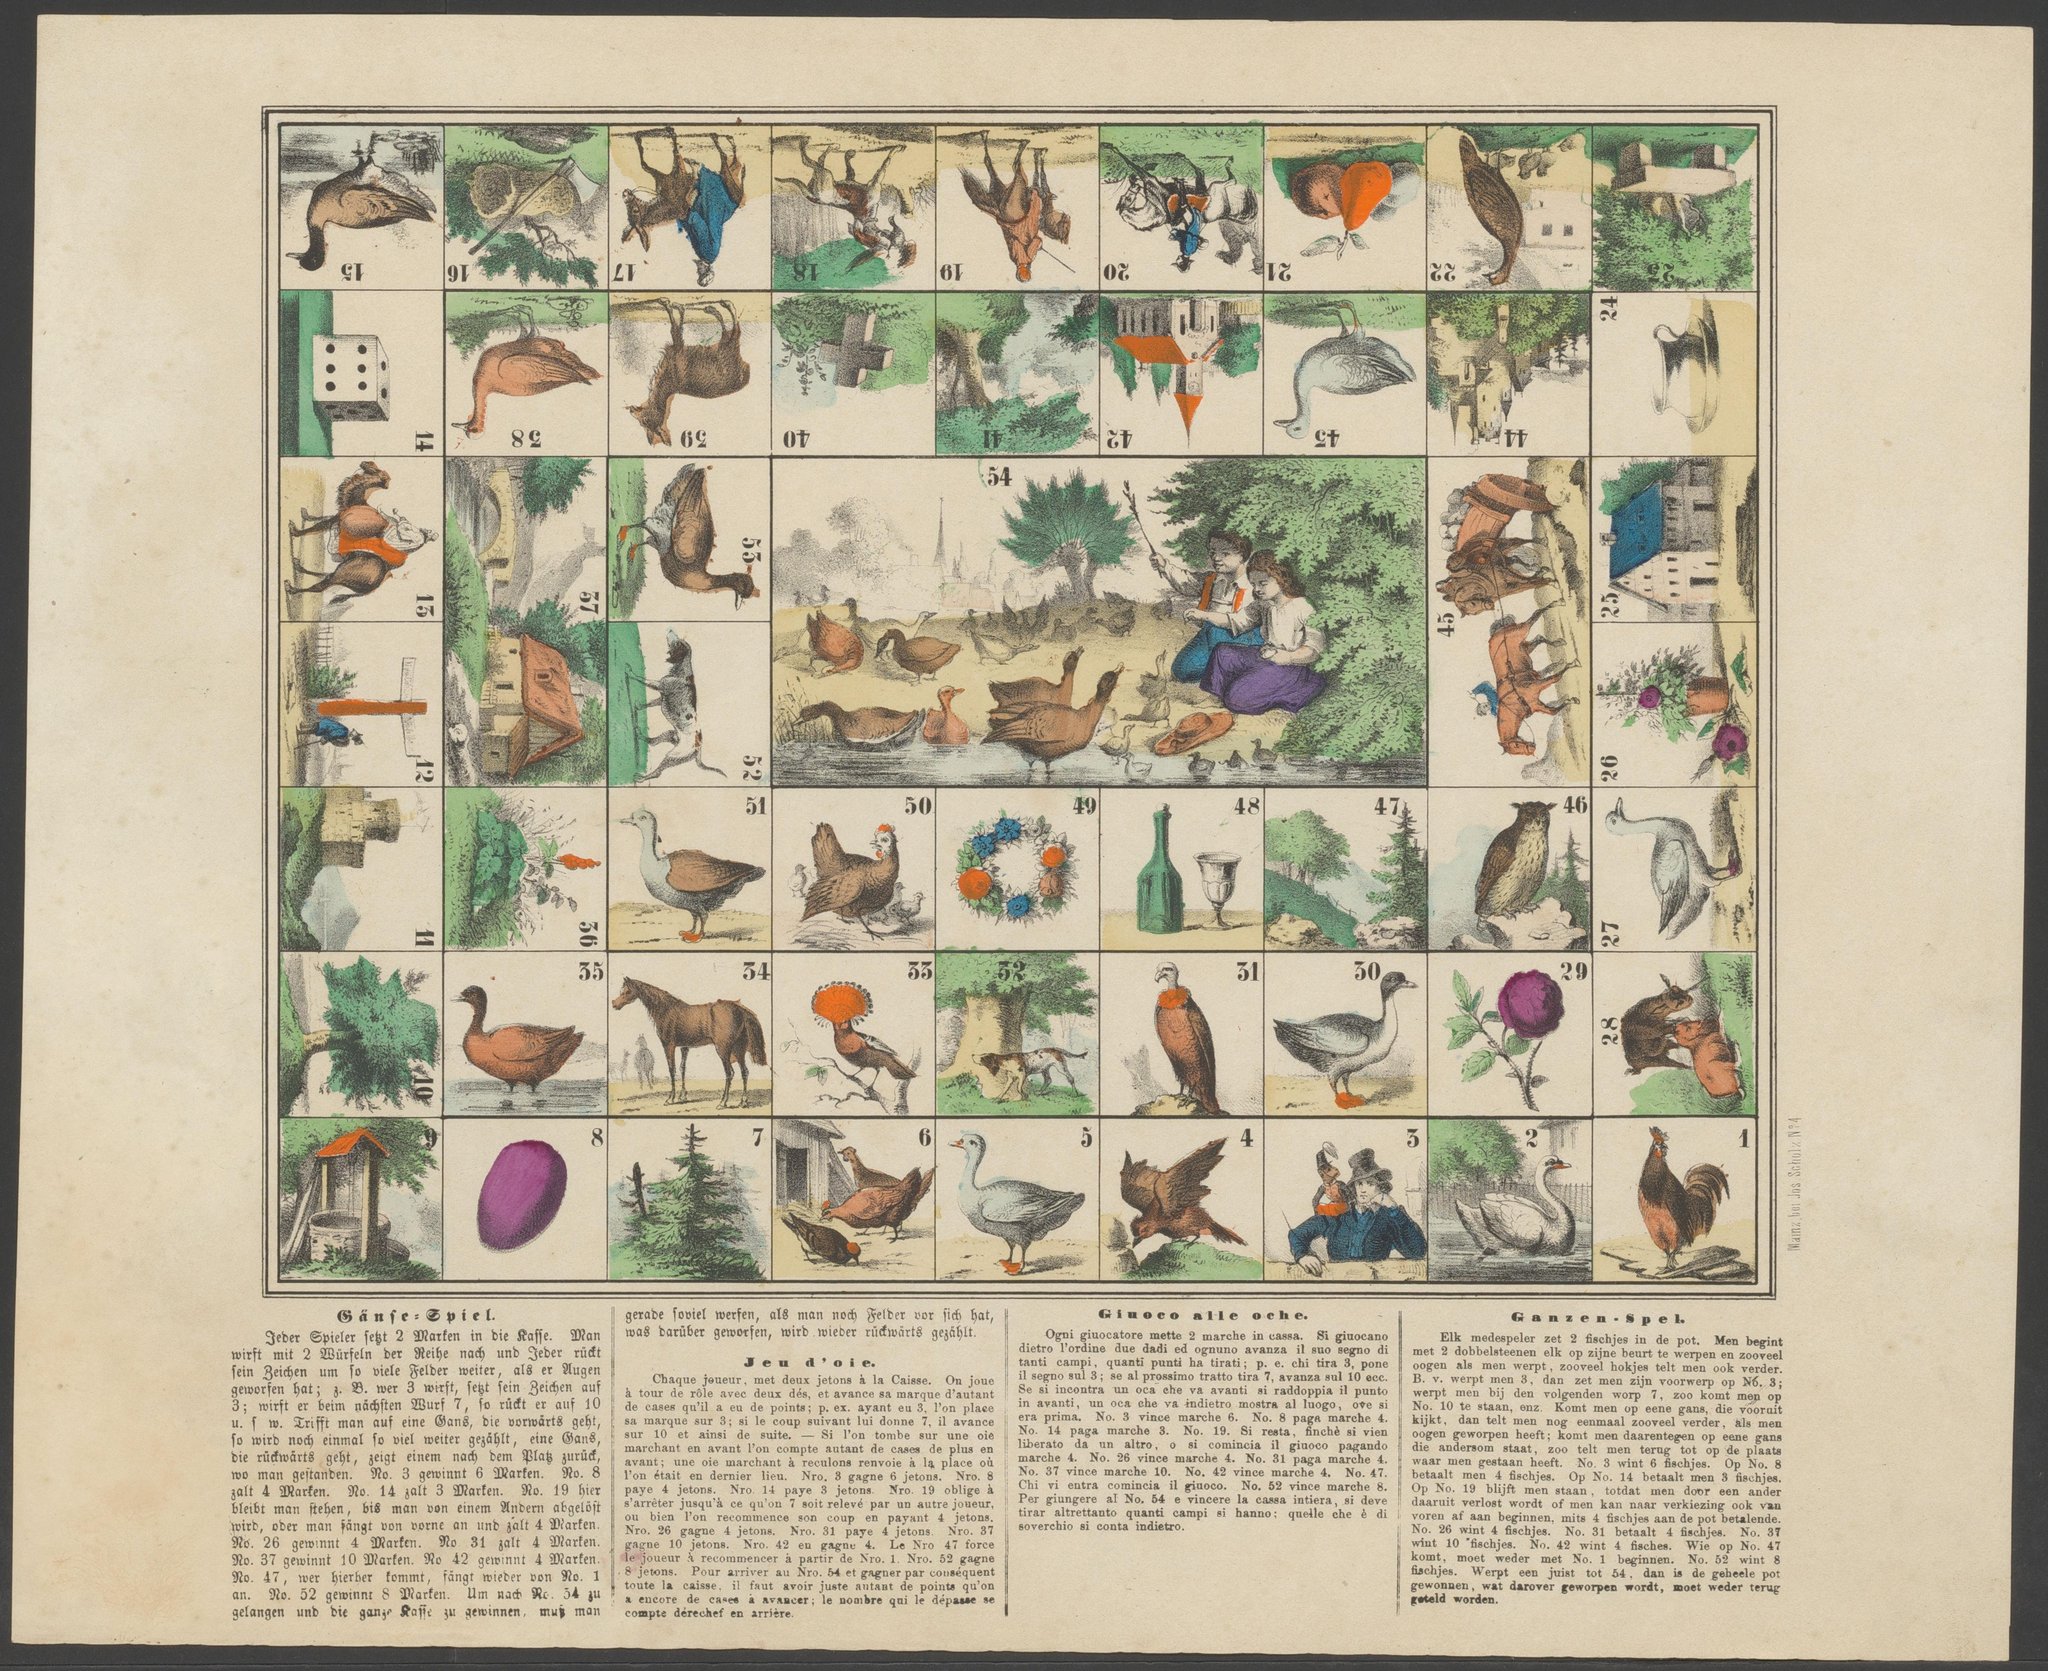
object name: print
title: Gänse-Spiel / Jeu d'Oie / Ginoco alle oche / Ganzen-Spel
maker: Anonymous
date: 1829-1880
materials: paper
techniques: hand coloring, letterpress printing, lithograph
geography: mainz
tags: water-birds: goose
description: Ganzenspel met 54 vakken. Het middelste vak is het grootst, hierin een jongen en een meisje bij een plas met watervogels. In de kleinere vakken ganzen, andere dieren, voorwerpen en gebouwen. Onderaan de uitleg van het spel in het Duits, Frans, Italiaans en Nederlands. Onderwerpsrubrieken binnen de Atlas Zeden en Gewoonten: Zeden en gewoonten in engeren zin, Spel en vermaak, Gezelschapsspel II, Ganzenbord en dergelijke.